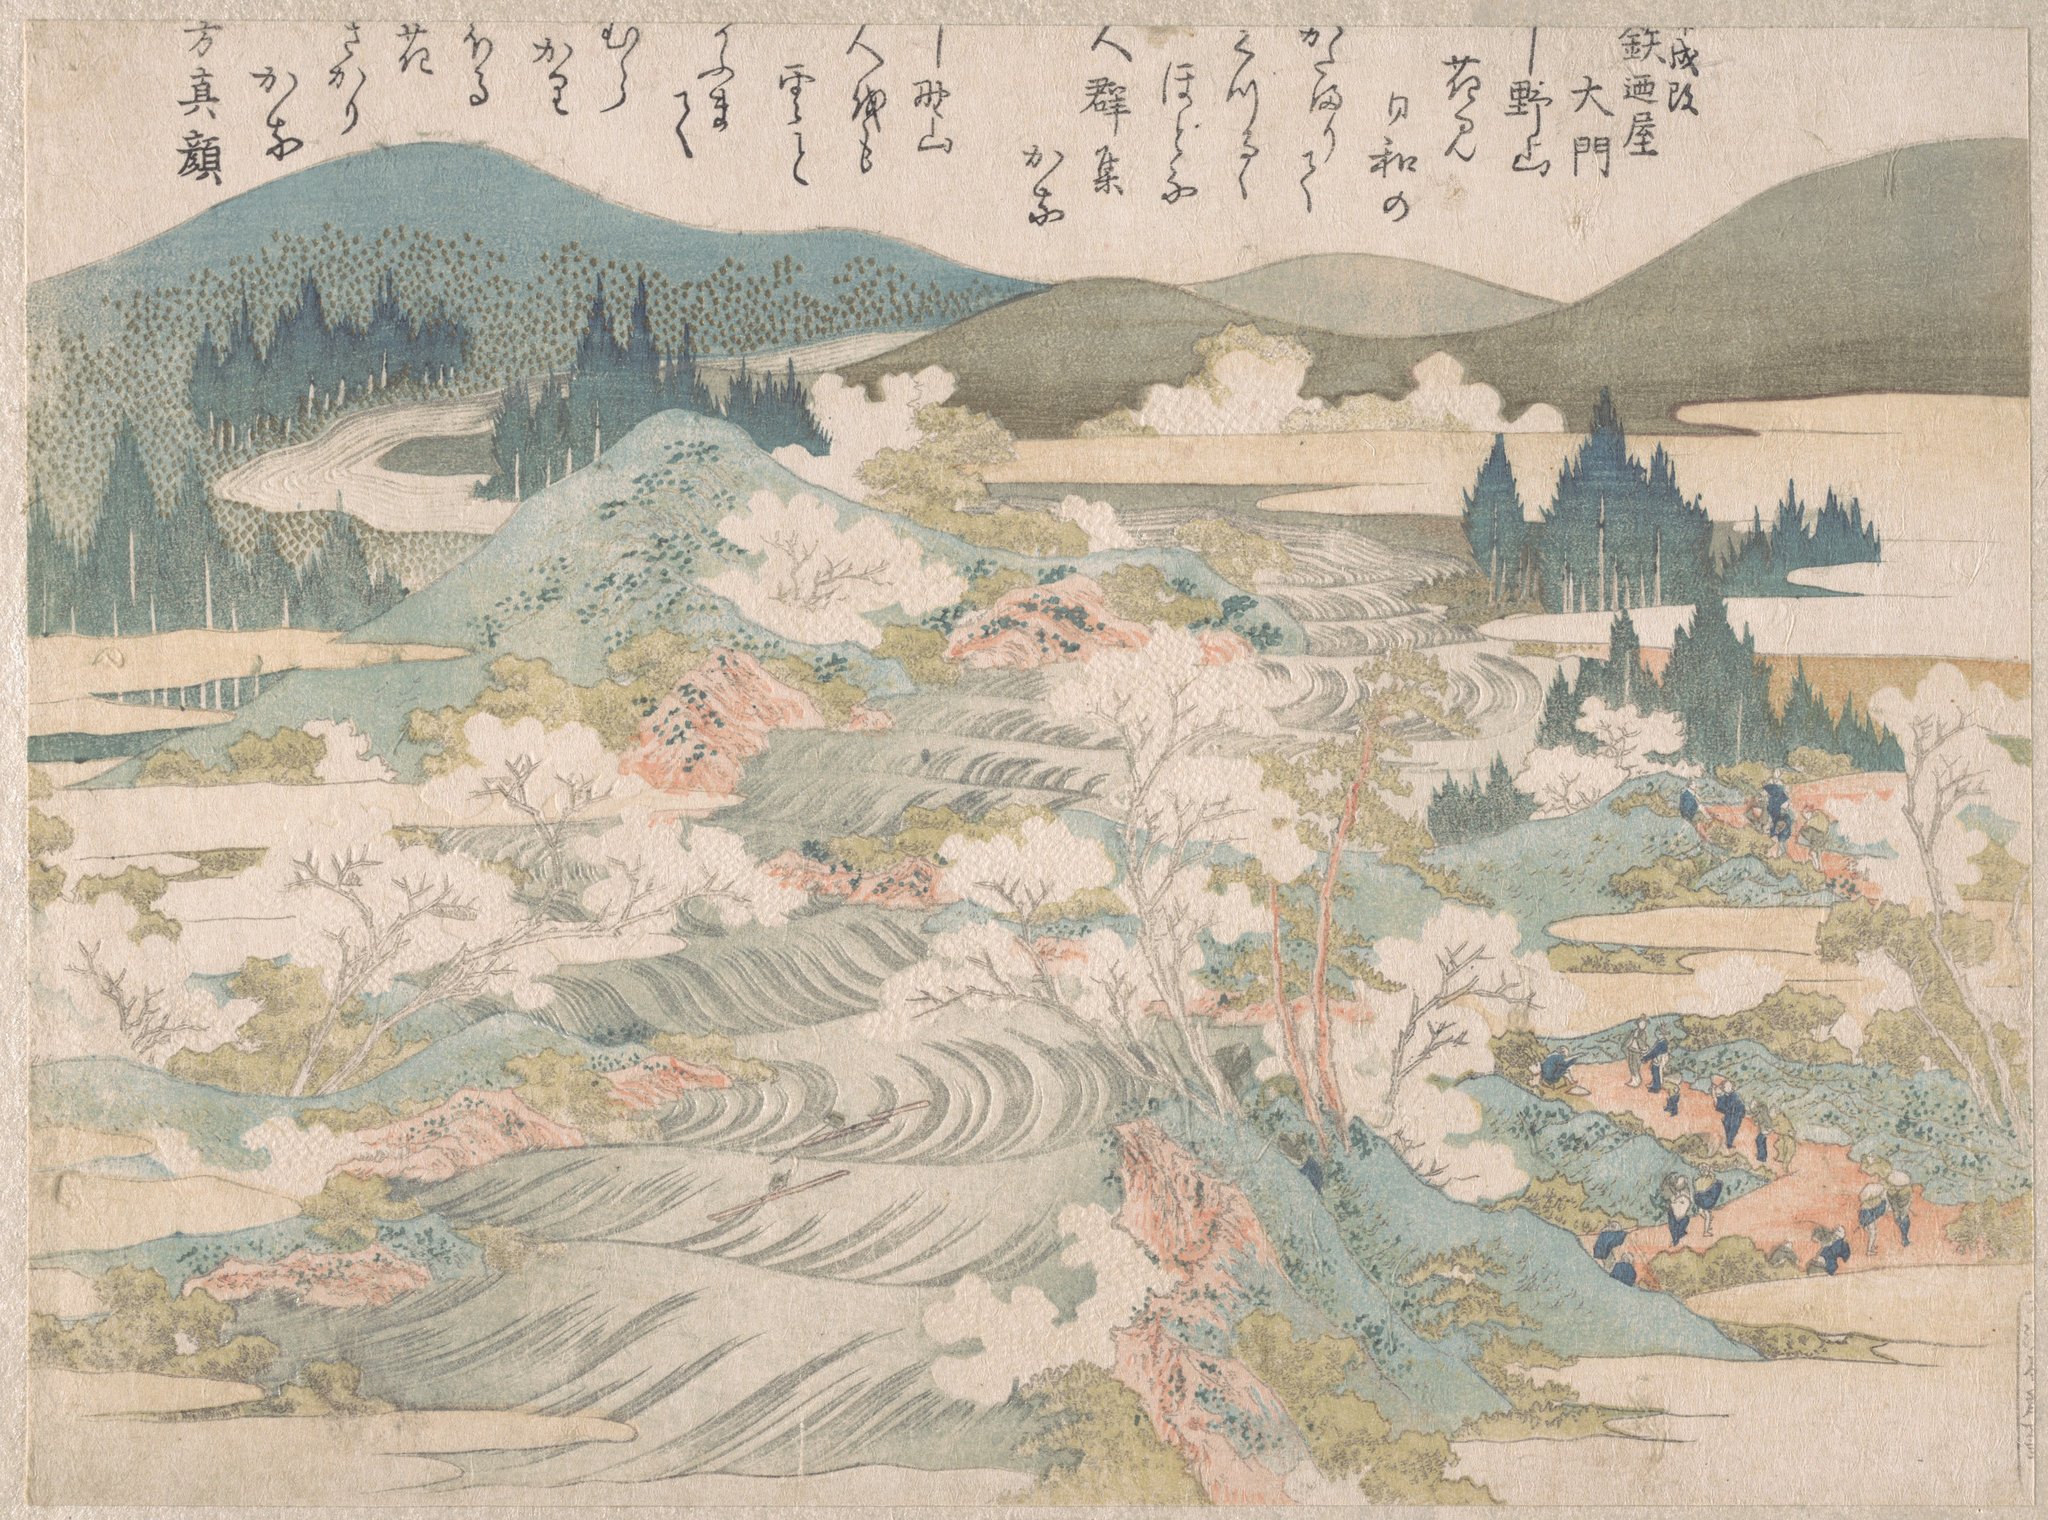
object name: print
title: Flowering Cherry Trees Along the Yoshino River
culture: japanese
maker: katsushika hokusai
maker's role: artist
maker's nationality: japanese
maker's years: 1760-1849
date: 1760-1849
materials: ink, paper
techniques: surimono, woodblock print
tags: rivers,mountains,trees